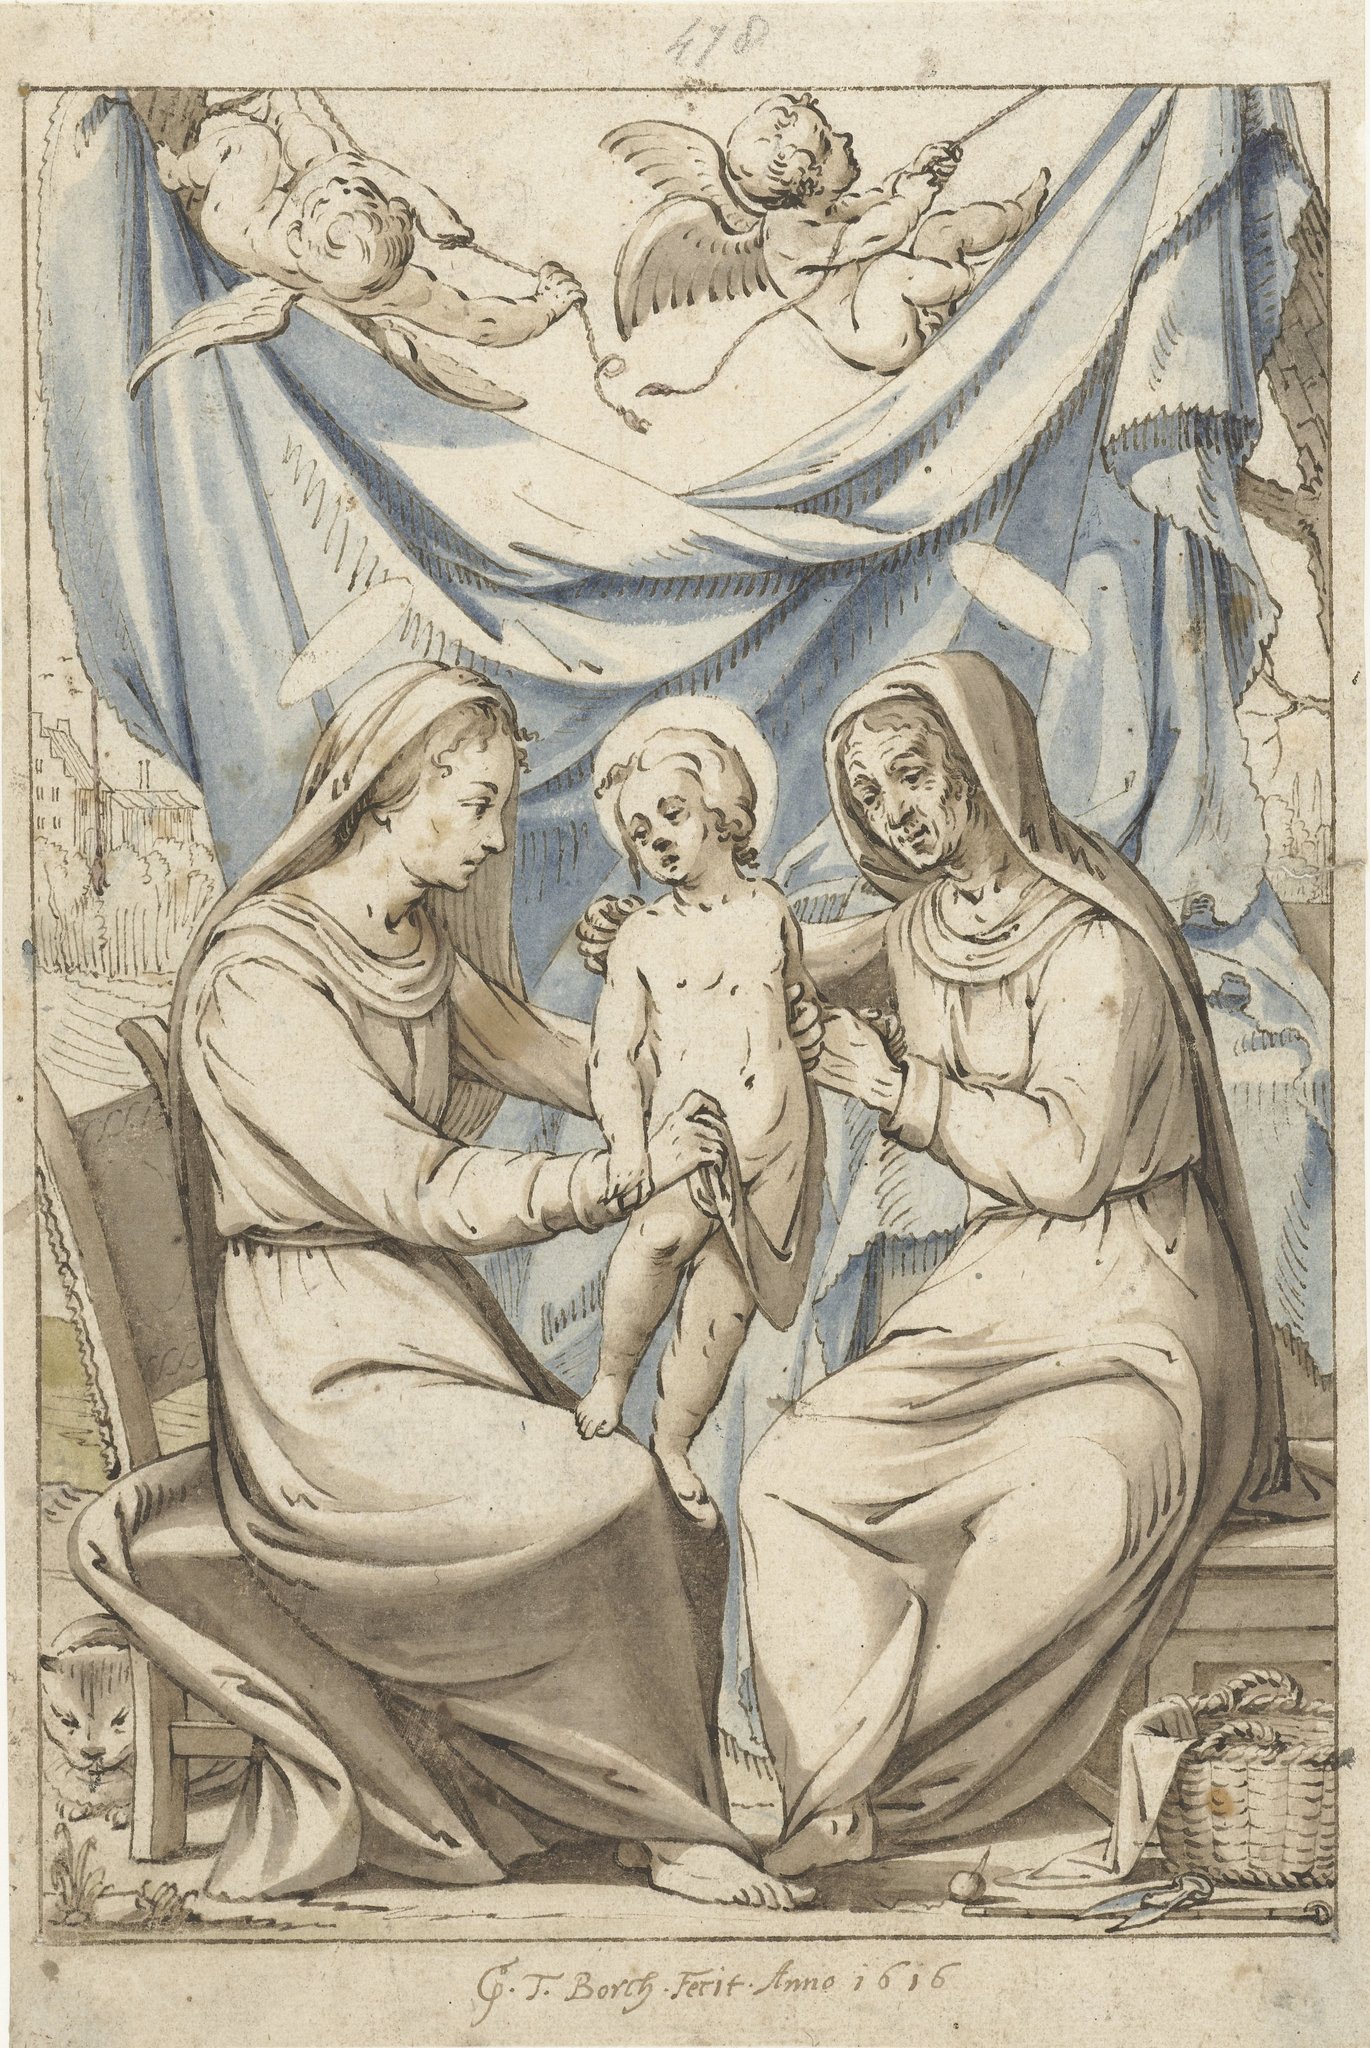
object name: drawing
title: De Maagd Maria met kind en de Heilige Anna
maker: gerard ter borch (i)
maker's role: draughtsman, print maker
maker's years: 1584-1662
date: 1616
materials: ink, paper, watercolor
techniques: brush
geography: zwolle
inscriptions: signature and date: ‘G.T.Borch.Fecit.Anno 1616’